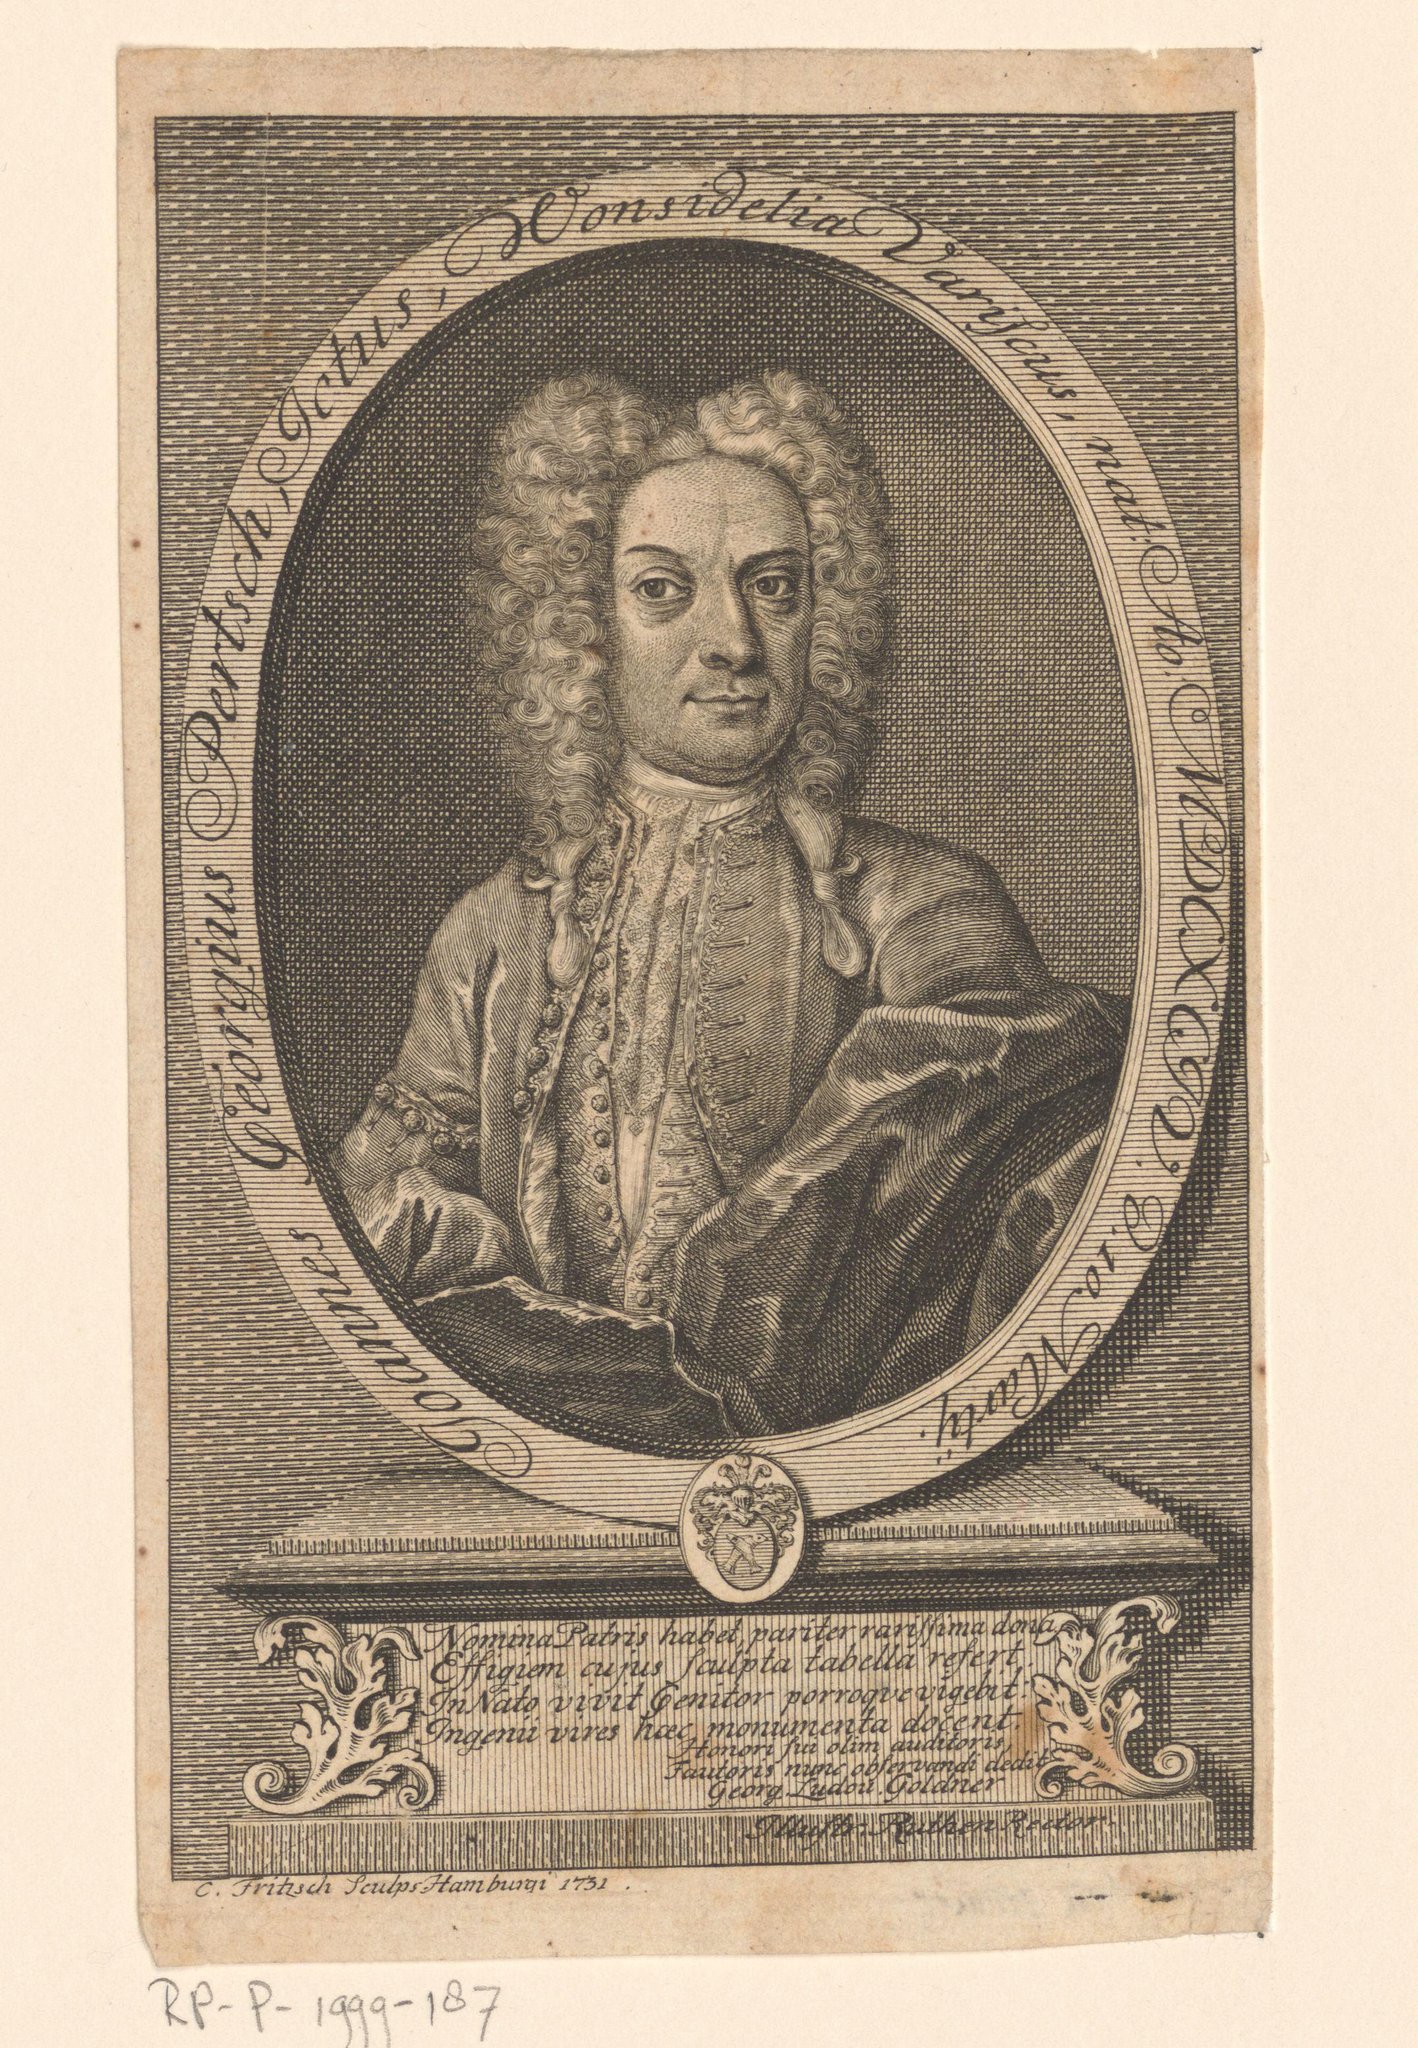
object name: print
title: Portret van Johann Georg Pertsch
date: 1731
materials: paper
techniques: engraving, etching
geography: hamburg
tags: adult man, historical persons, armorial bearing, heraldry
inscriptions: collector's mark: Lugt 2228, inscription: ‘Portr. 60516/ Pertsch/ LB XXIV 442875’, collector's mark: Lugt 2760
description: Buste van voren gezien, met pruik, in ovaal met randschrift. Onderschrift in het Latijn op een pedestal.